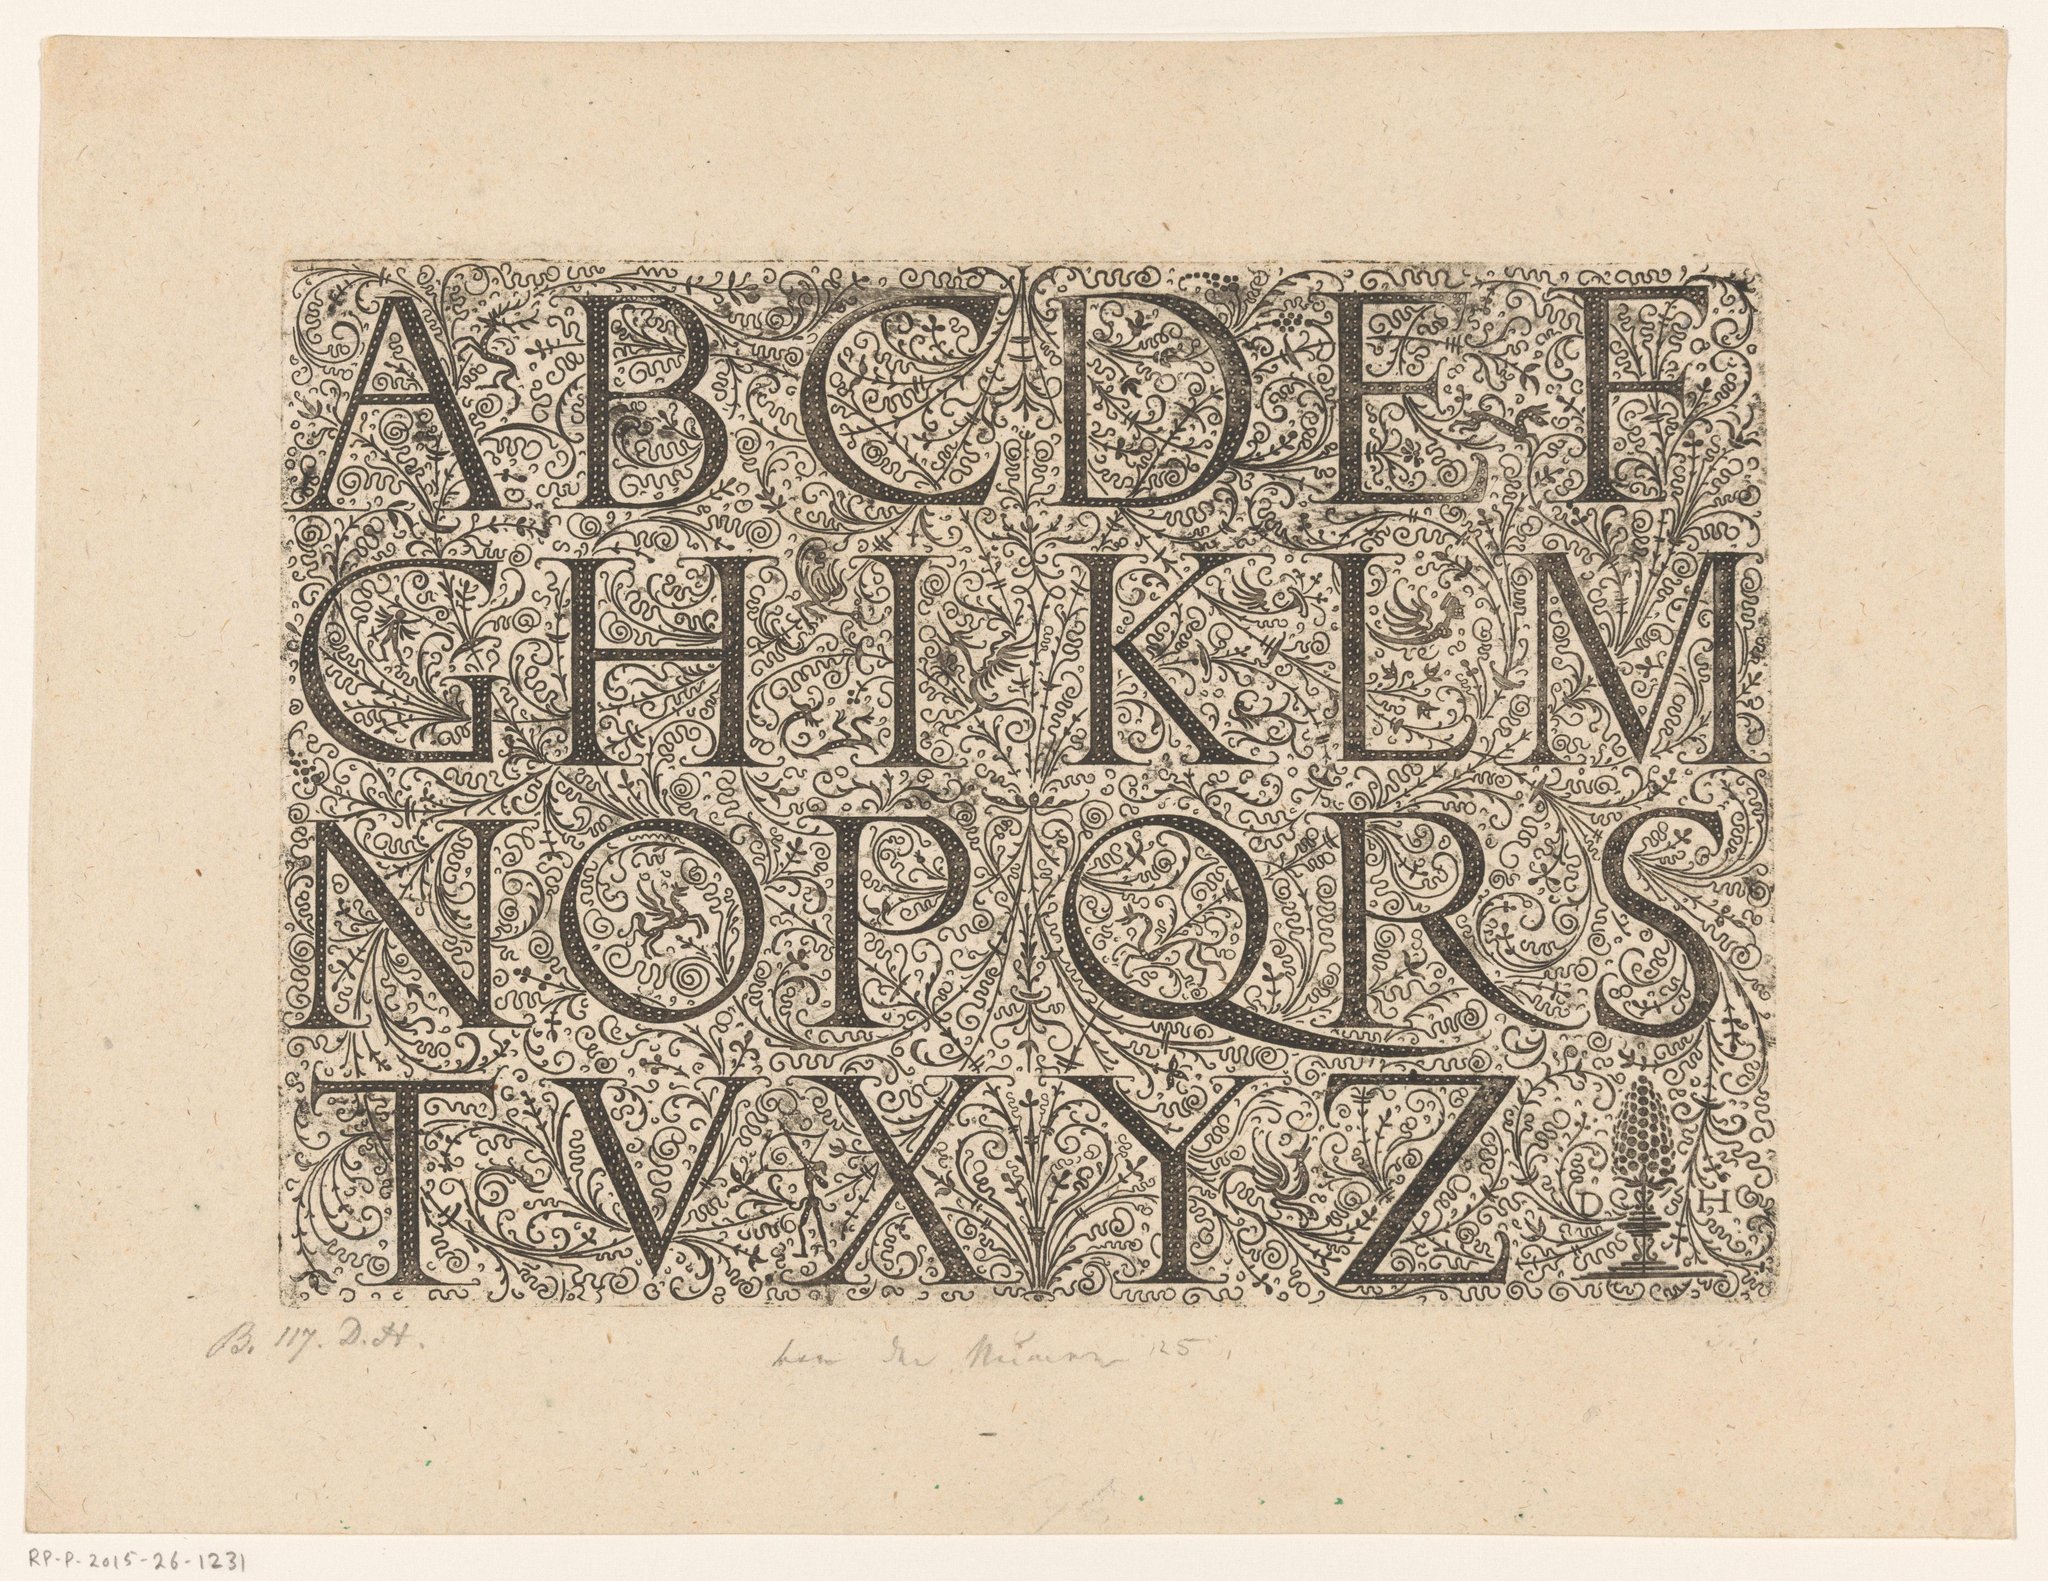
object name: print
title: Alfabet tegen een gedecoreerde achtergrond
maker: daniel hopfer (i)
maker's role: print maker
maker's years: 1470-1536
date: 1490-1536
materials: paper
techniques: etching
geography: augsburg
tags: ornament derived from animal forms, roman script; scripts based on the roman alphabet, unidentifiable plant forms ~ ornament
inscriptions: watermark, collector's mark: Lugt 2228, collector's mark: Lugt 4779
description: De letters in Romeinse majuskel, verdeeld over vier horizontale lijnen.